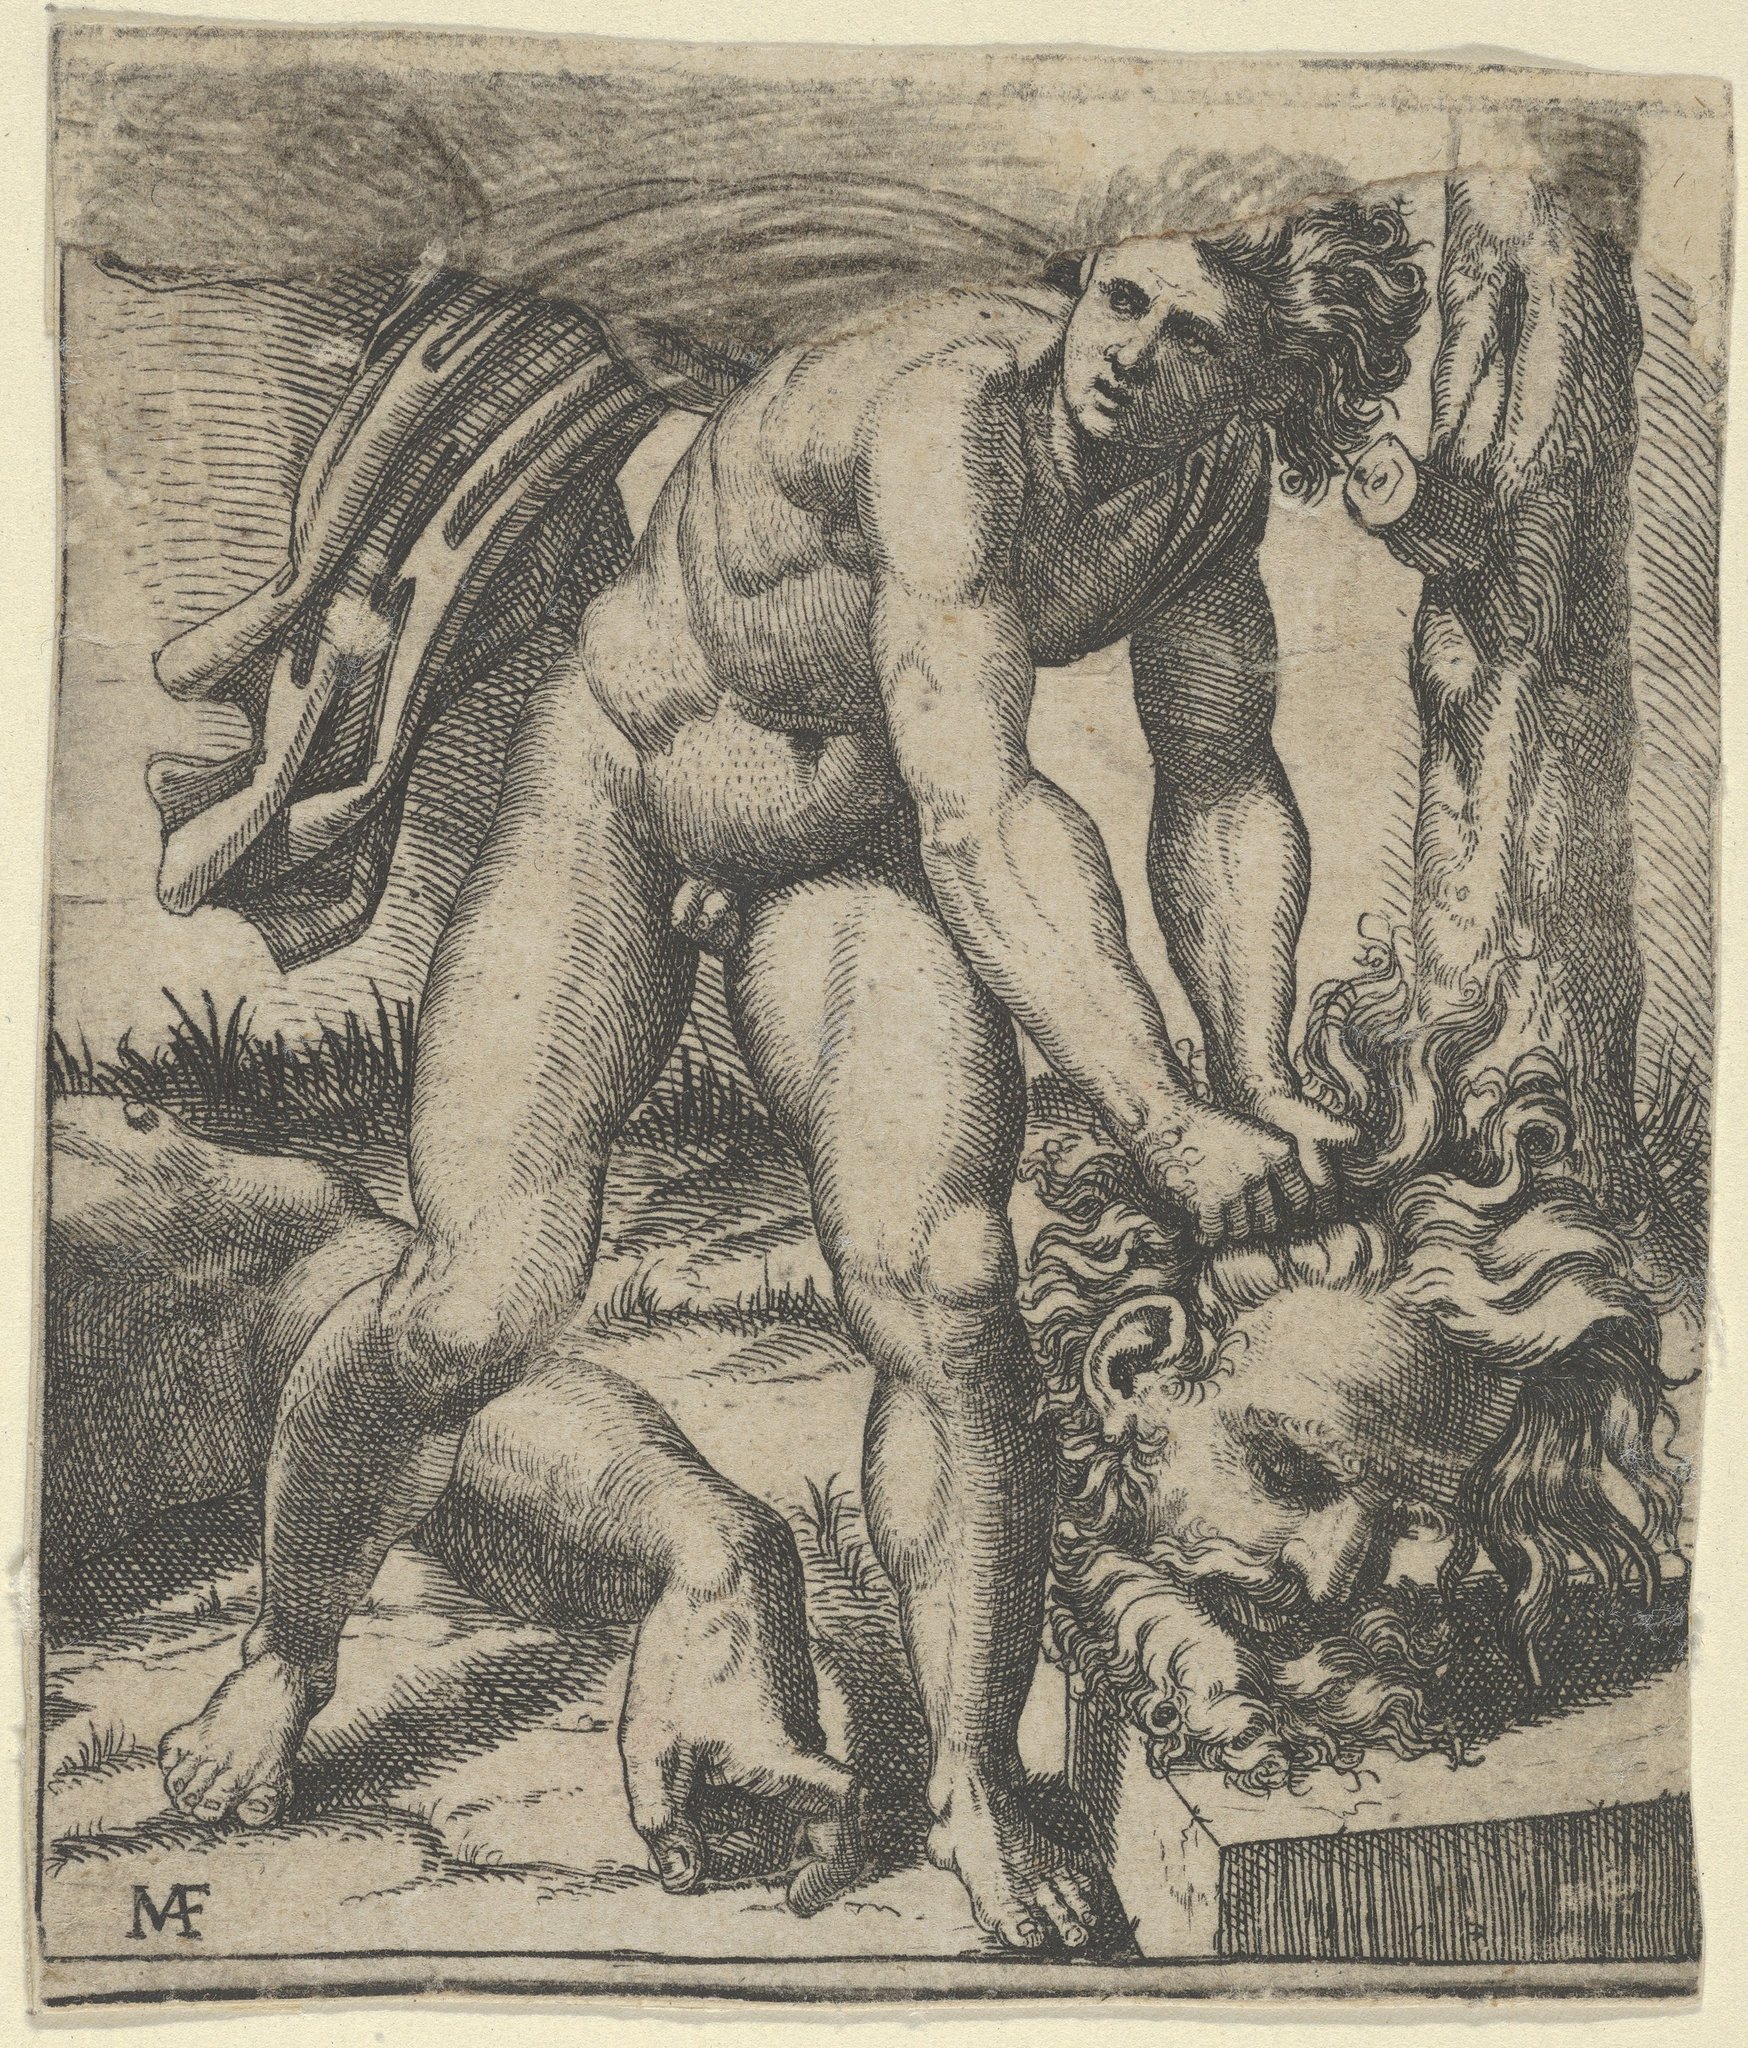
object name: print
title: David with the head of Goliath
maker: marcantonio raimondi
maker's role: artist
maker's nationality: italian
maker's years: 1475-1534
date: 1515-1516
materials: pencil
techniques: engraving, etching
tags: heads,david